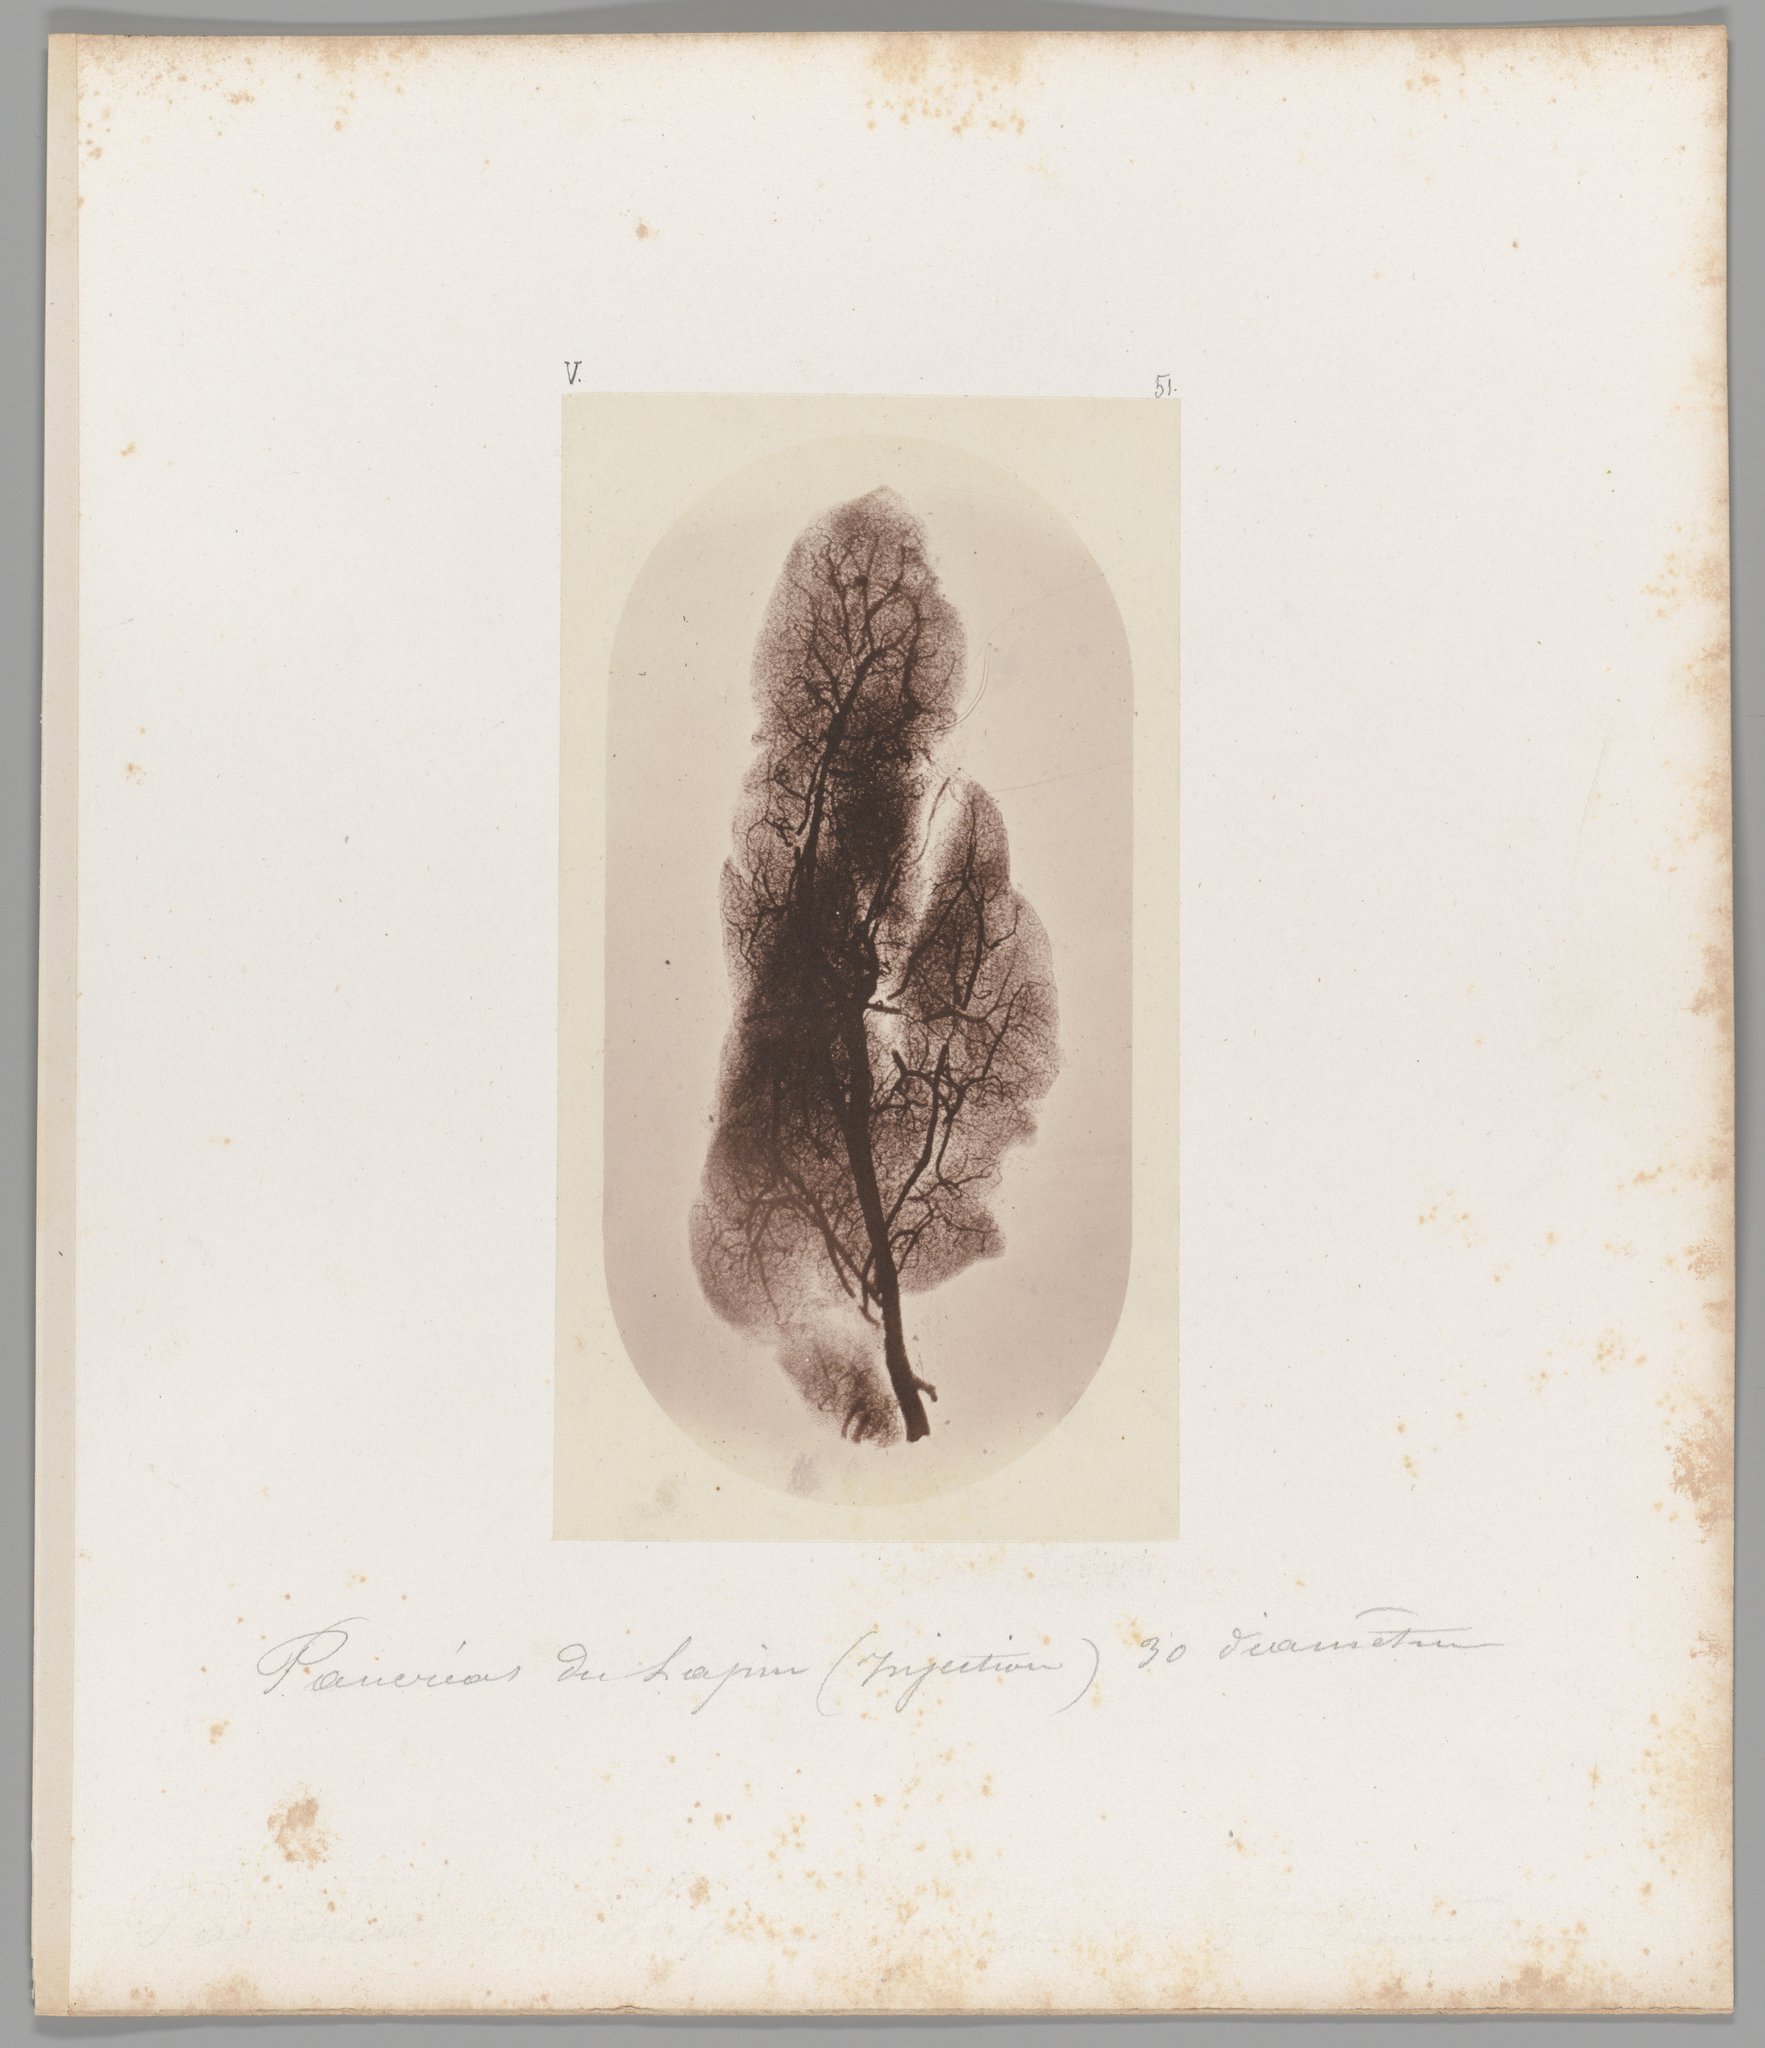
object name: photograph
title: [Untitled]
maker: auguste-adolphe bertsch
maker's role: artist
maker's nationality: french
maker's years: 1813-1871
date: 1853-1857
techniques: salted paper print